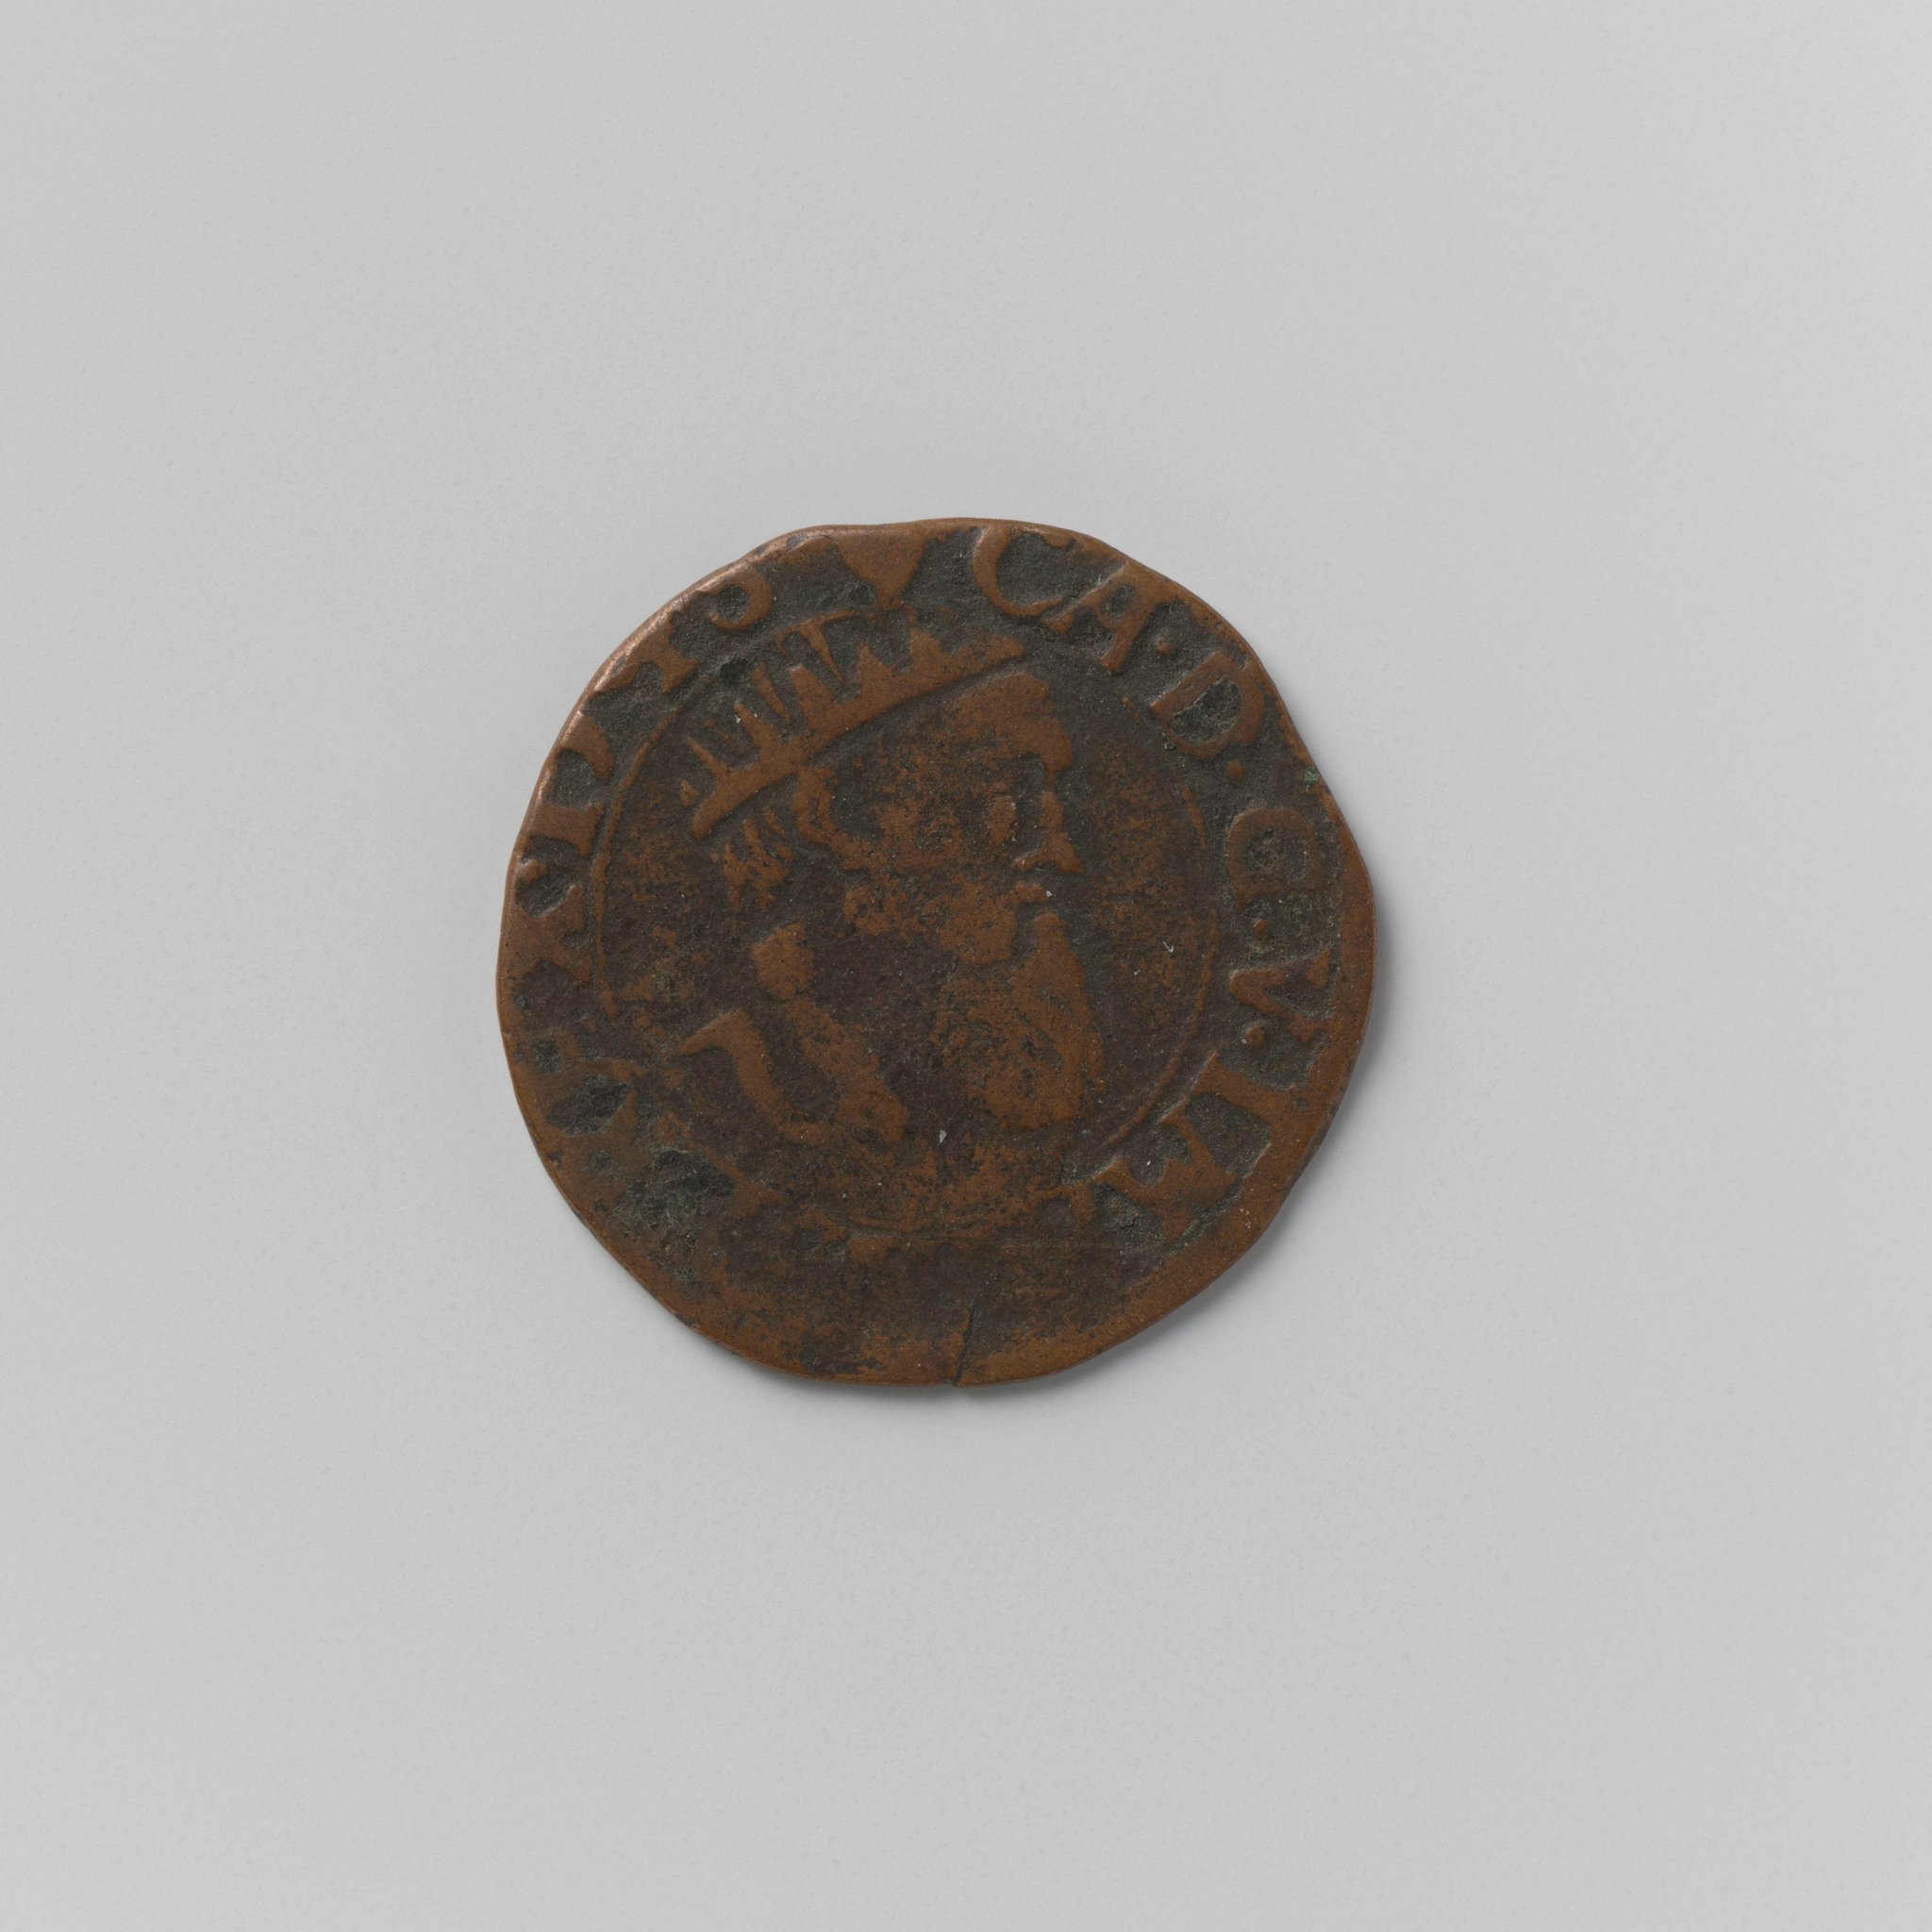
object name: coin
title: Korte uit Brabant van Karel V, 1543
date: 1543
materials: copper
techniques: striking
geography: antwerp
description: Koperen munt. Voorzijde: hoofd van Karel V met stralenkrans naar rechts. Jaartal in omschrift. Keerzijde: in een randversiering klimmende leeuw naar links. Geen omschrift.